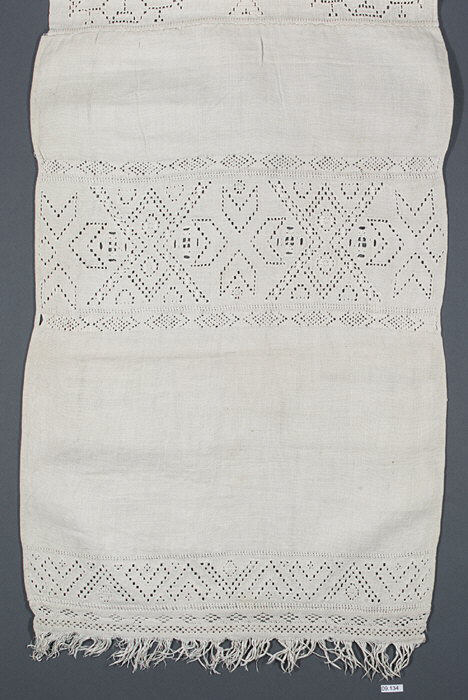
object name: cover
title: Towel cover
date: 1801-1833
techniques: embroidery